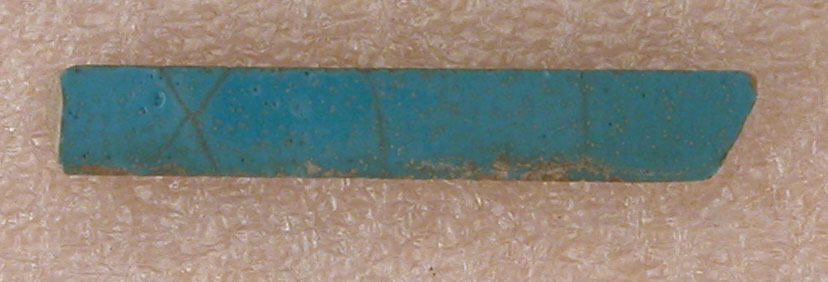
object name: tile fragment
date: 1334-1434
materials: stonepaste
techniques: glazing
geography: uzbekistan